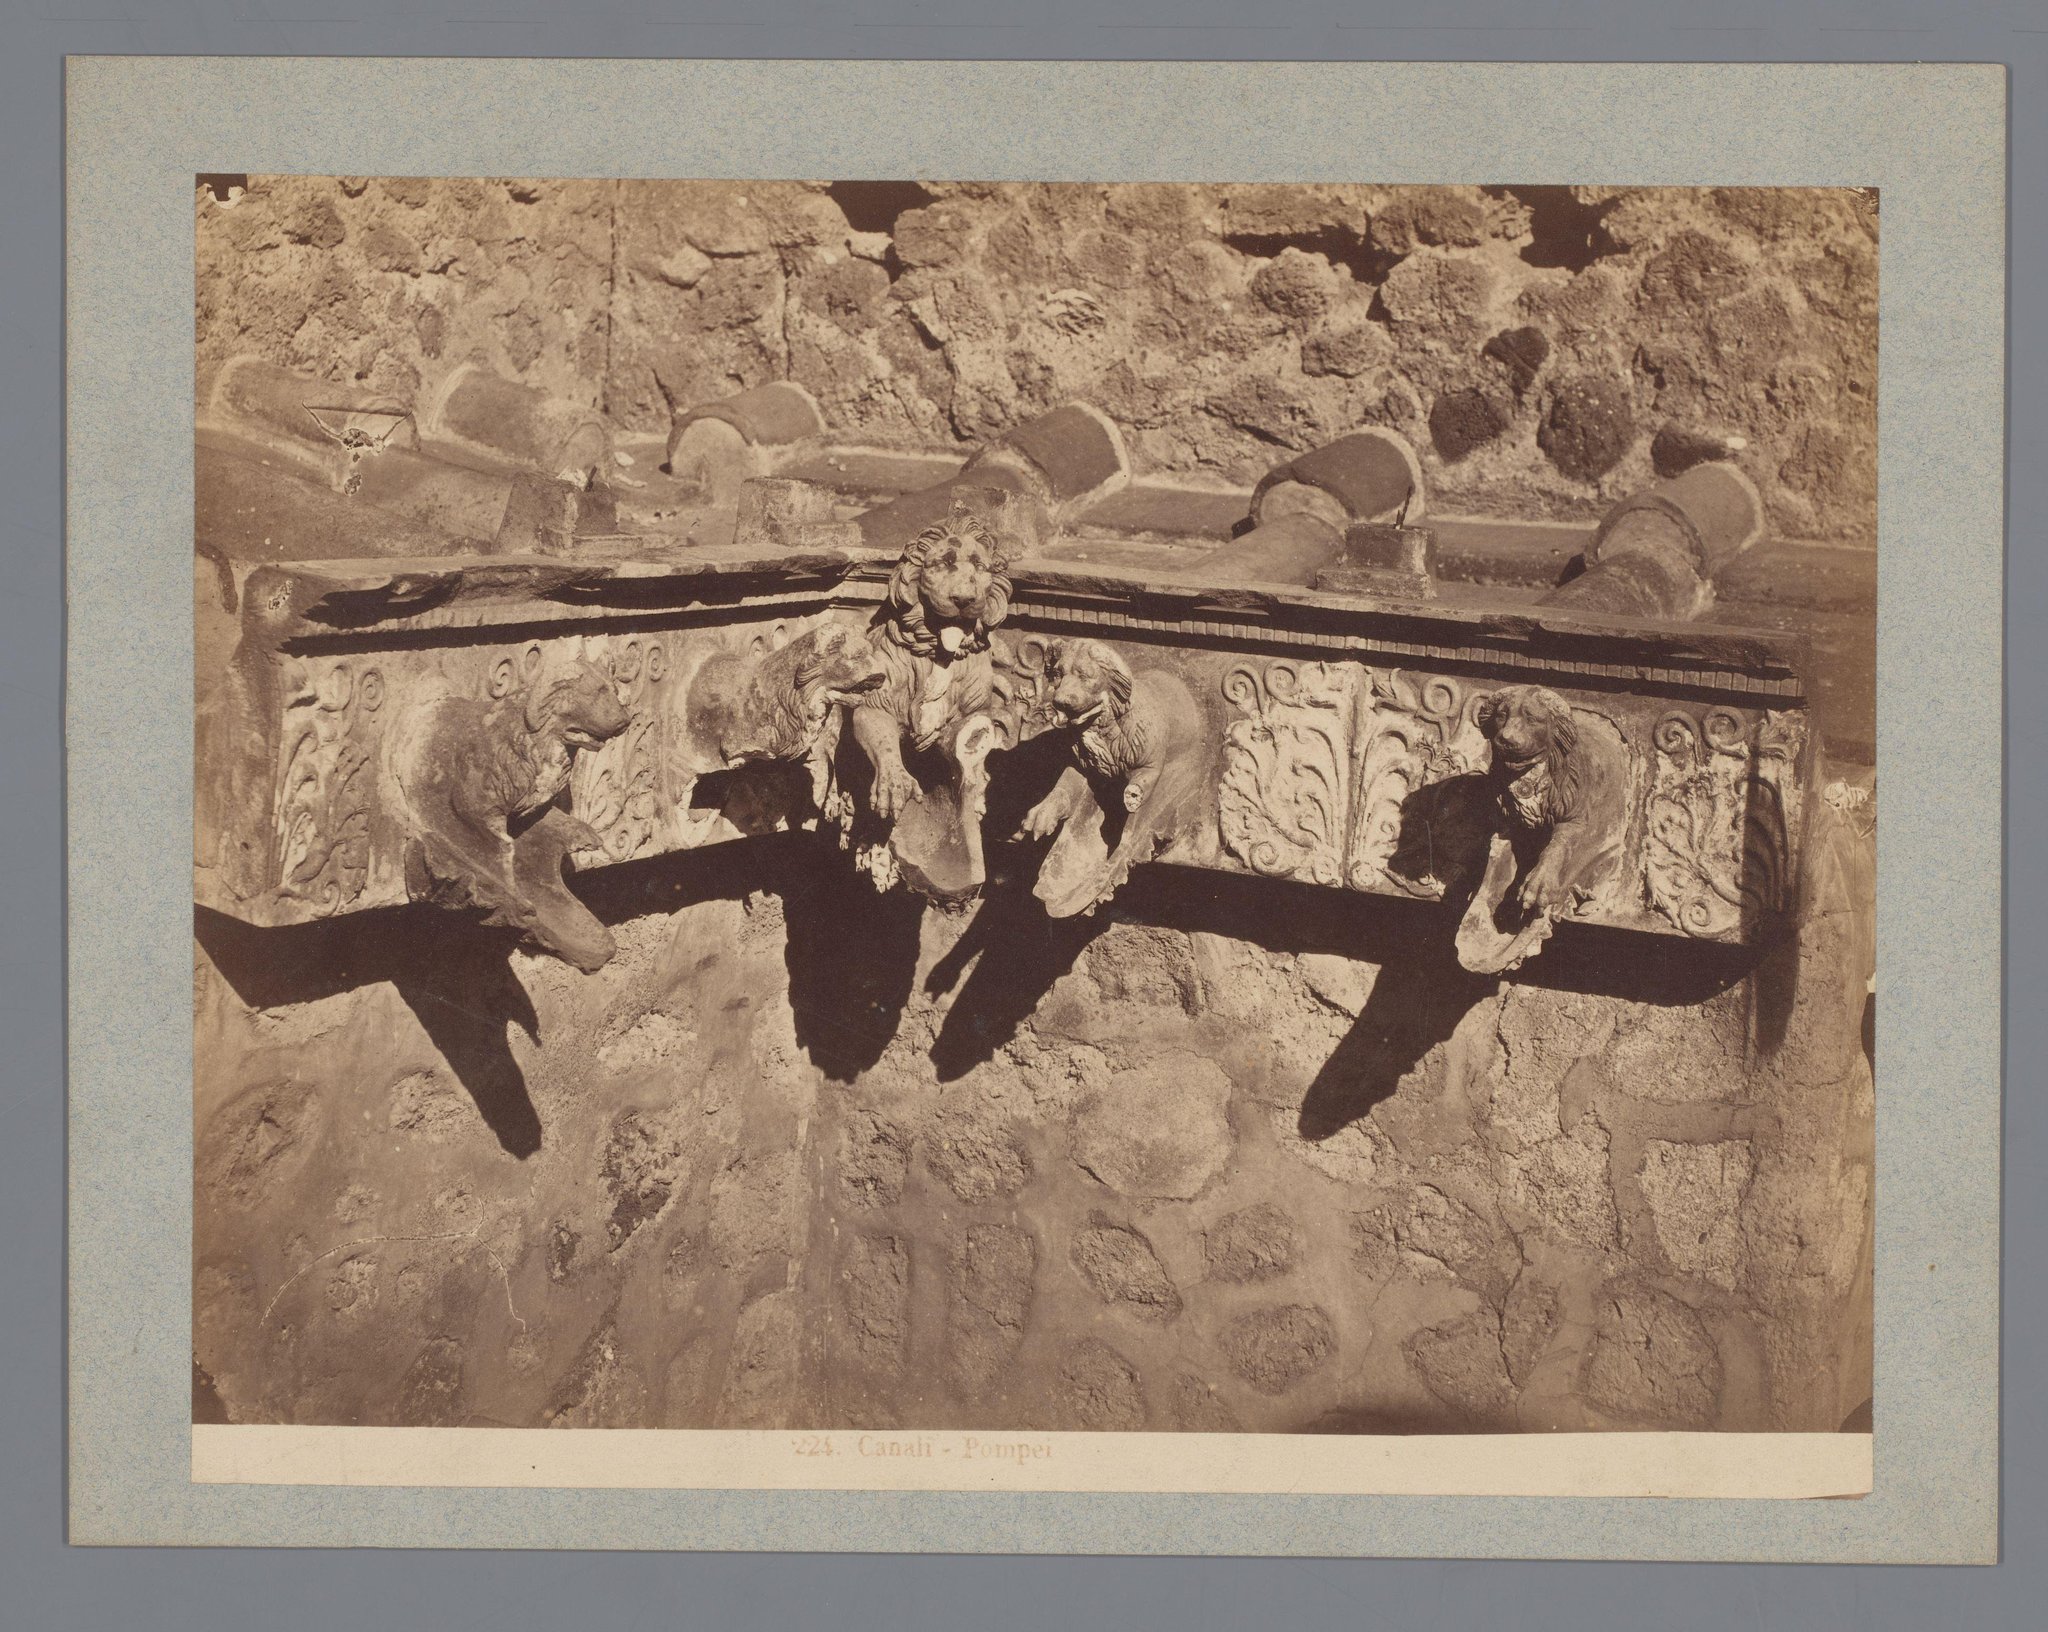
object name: photograph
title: Canali - Pompei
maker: Anonymous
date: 1851-1900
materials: cardboard, paper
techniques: albumen print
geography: pompeii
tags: water-supply and draining, pipework (in house or building), pompeii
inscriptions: number: ‘224.’